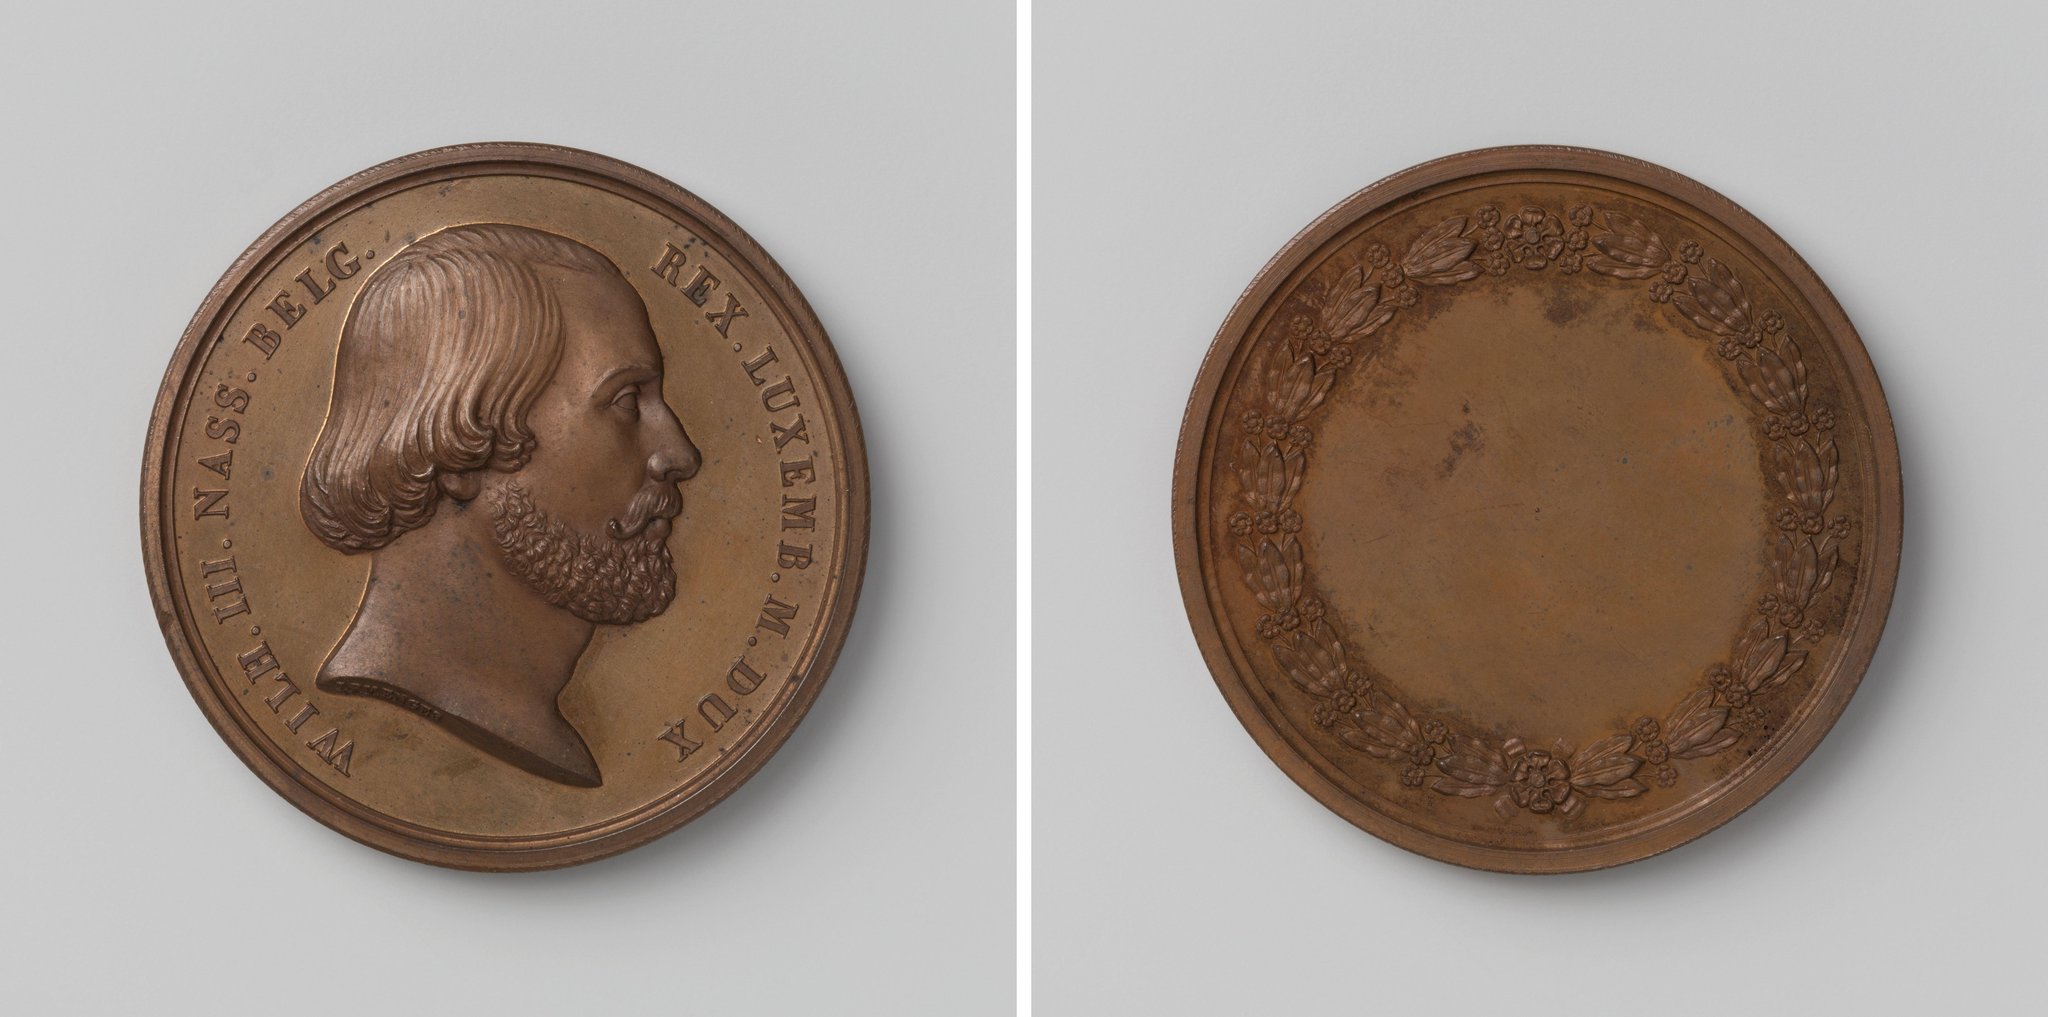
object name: medal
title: Willem III, koning der Nederlanden, penning van de derde grootte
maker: johan philip menger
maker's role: medailleur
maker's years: 1818-1895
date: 1849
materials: bronze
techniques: striking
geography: utrecht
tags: willem iii (koning der nederlanden)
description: Bronzen penning. Voorzijde: borststuk man binnen omschrift. Keerzijde: blanco veld binnen krans van myrtebladeren